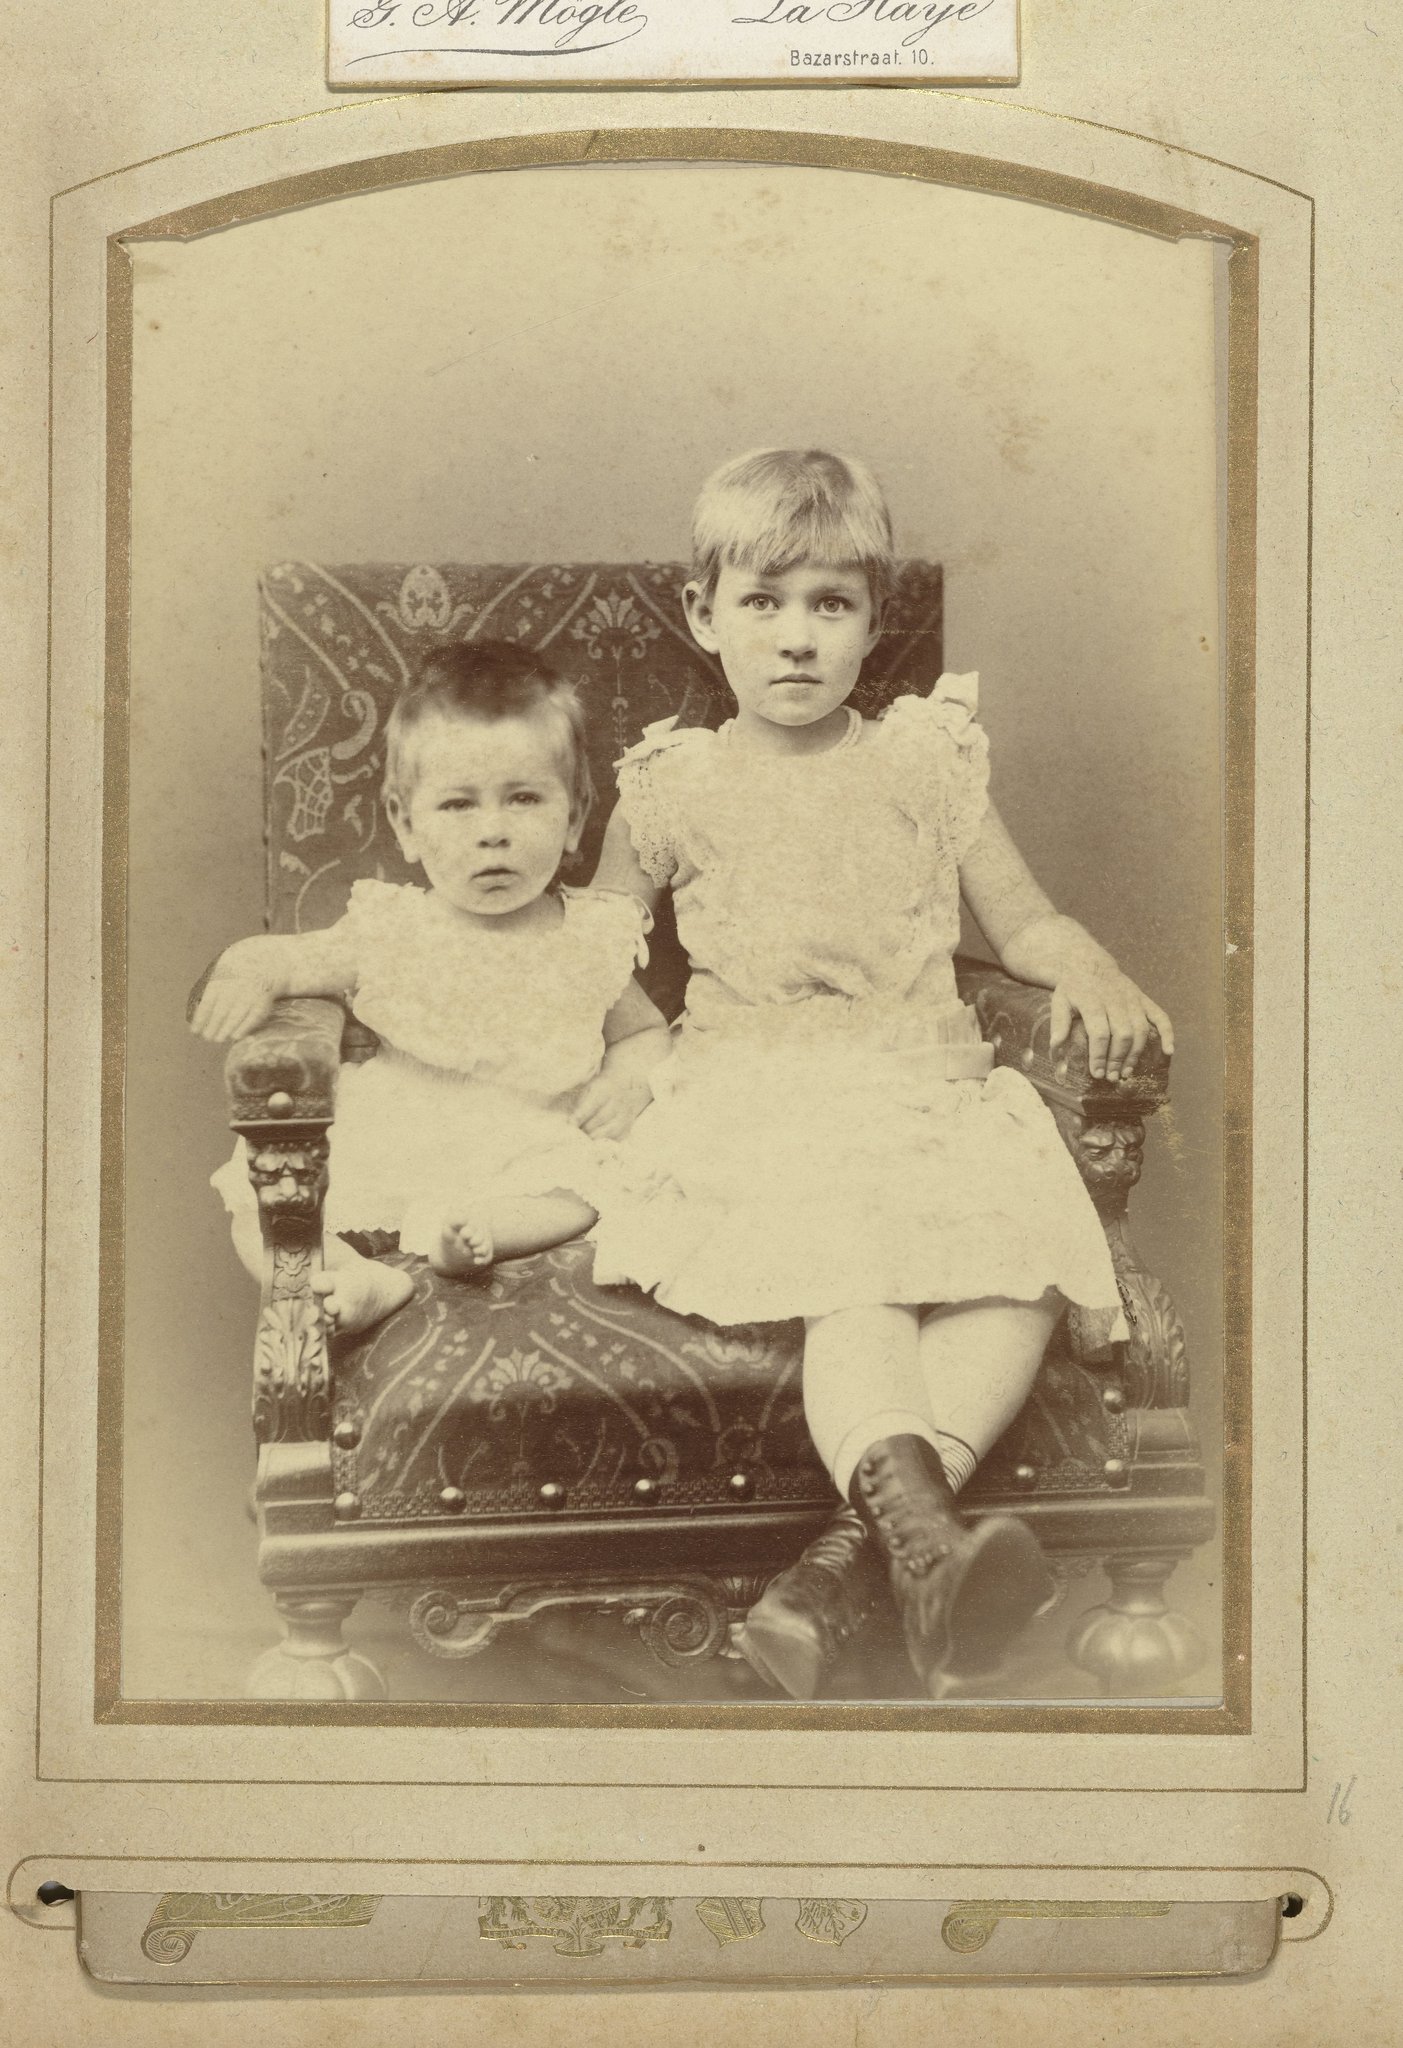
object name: photograph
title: Portret van An Kessler en Guus Kessler op een stoel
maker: richard kameke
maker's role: fotograaf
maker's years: 1847-1898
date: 1889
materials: paper, photographic support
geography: the hague